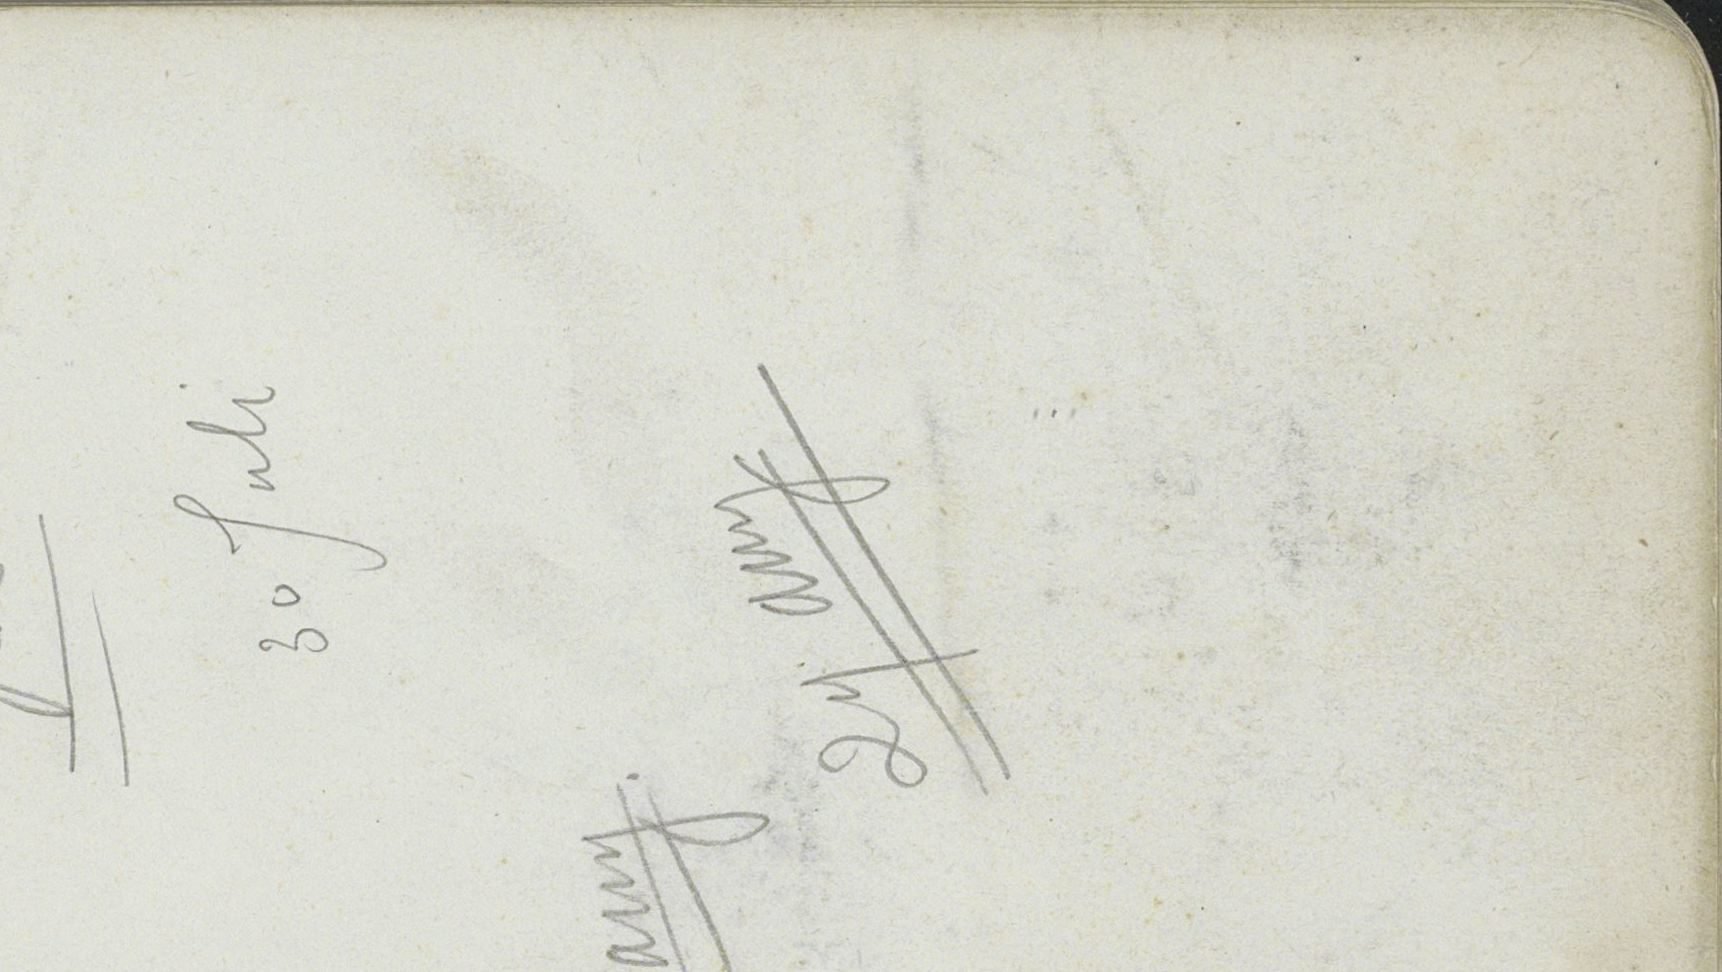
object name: sketchbook leaf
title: Data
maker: carel adolph lion cachet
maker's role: draughtsman, print maker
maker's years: 1864-1945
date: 1905-1906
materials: paper, pencil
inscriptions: annotation: ‘25 Juli[....]/ 30 Juli/ 1 aug./ 29 aug’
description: Blad 1 recto uit een schetsboek met 34 bladen.